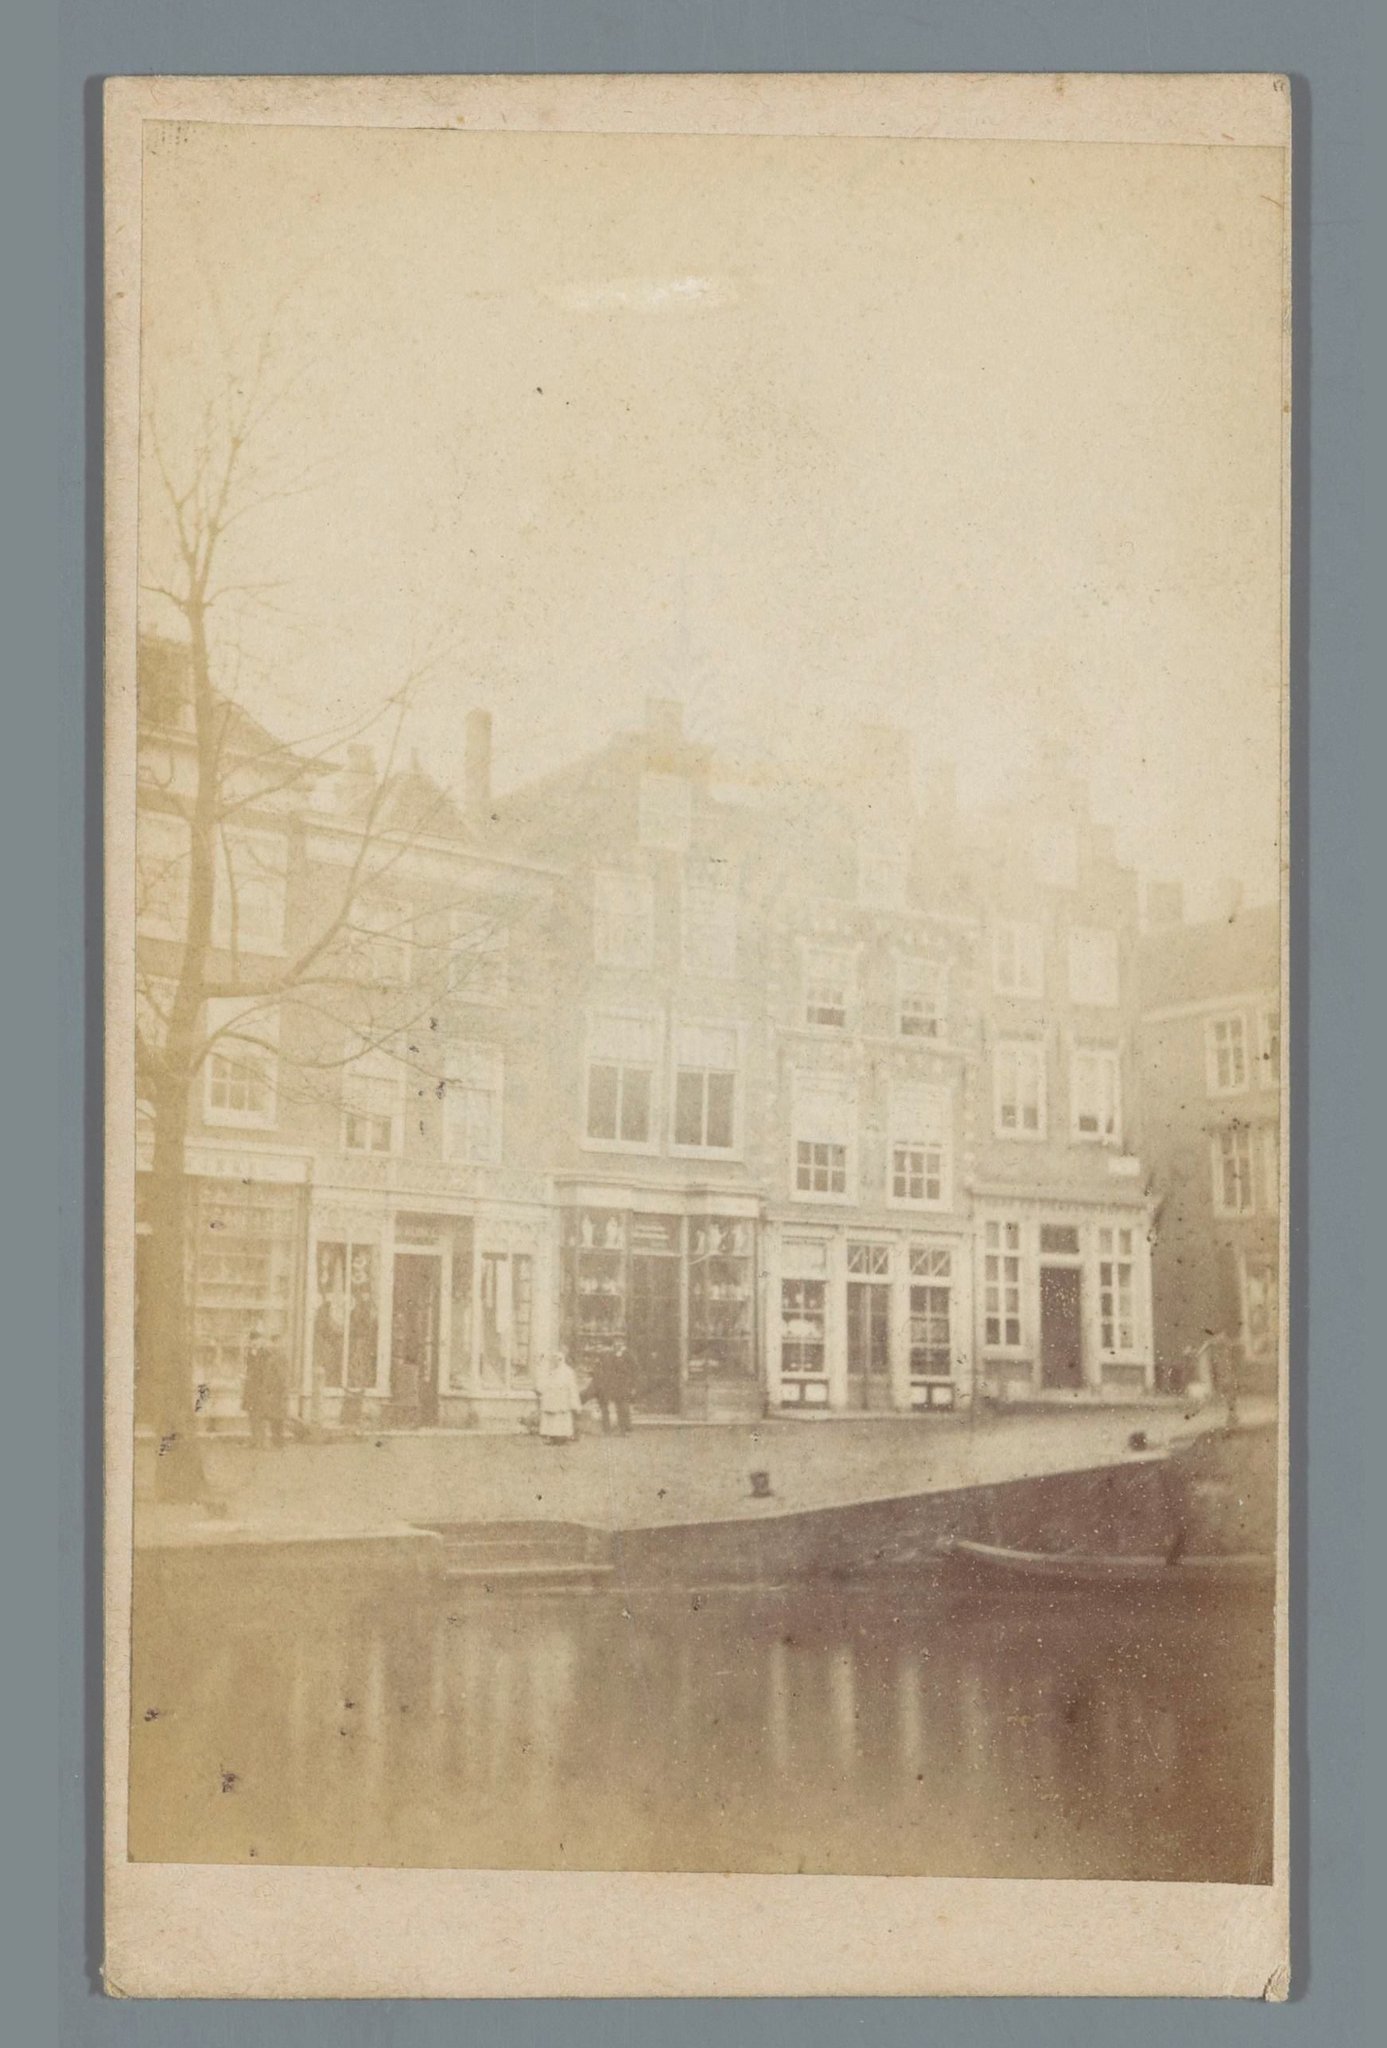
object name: carte de visite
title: Gezicht op de Botermarkt te Leiden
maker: jan goedeljee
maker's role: fotograaf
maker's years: 1824-1905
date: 1850-1900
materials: cardboard, photographic support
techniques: albumen print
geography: leiden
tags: city-view in general; 'veduta', canals, waters (in city), leiden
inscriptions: inscription: ‘Botermarkt’